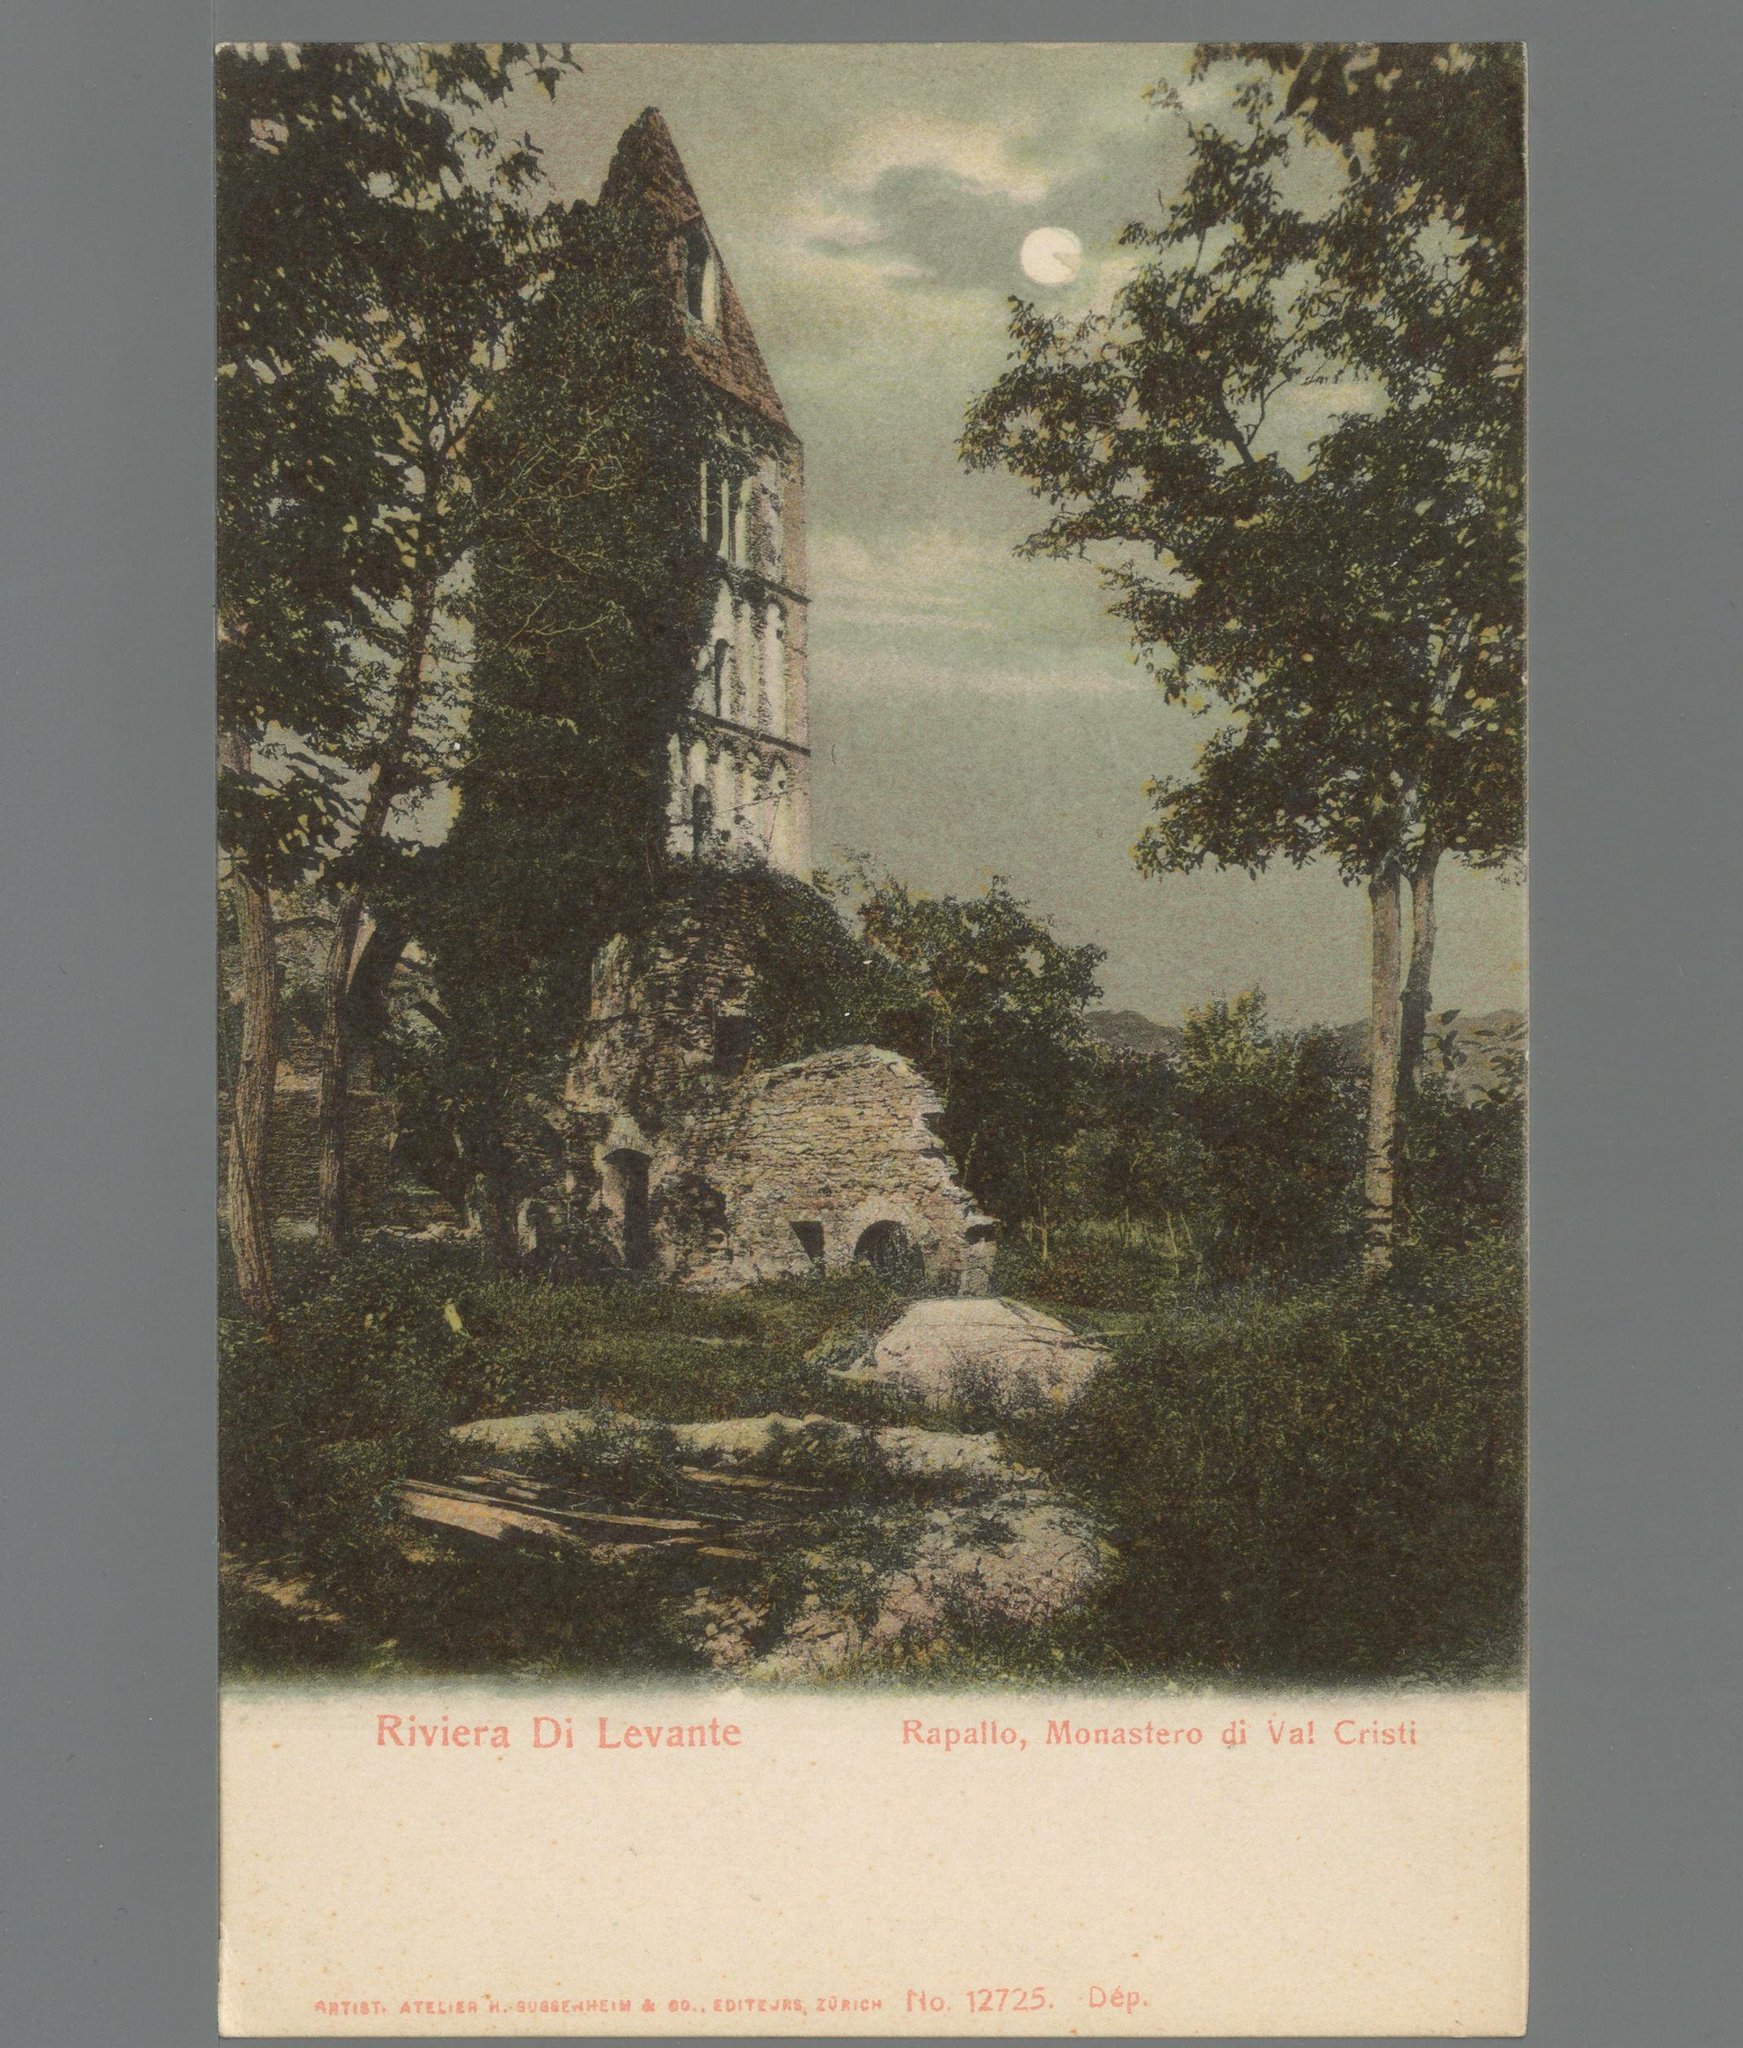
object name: photomechanical print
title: Rapallo. Monasterio di Val Christi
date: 1893-1905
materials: cardboard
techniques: photograph, lithograph, writing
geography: rapallo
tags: landscapes in the temperate zone, ruin of church, monastery, etc.